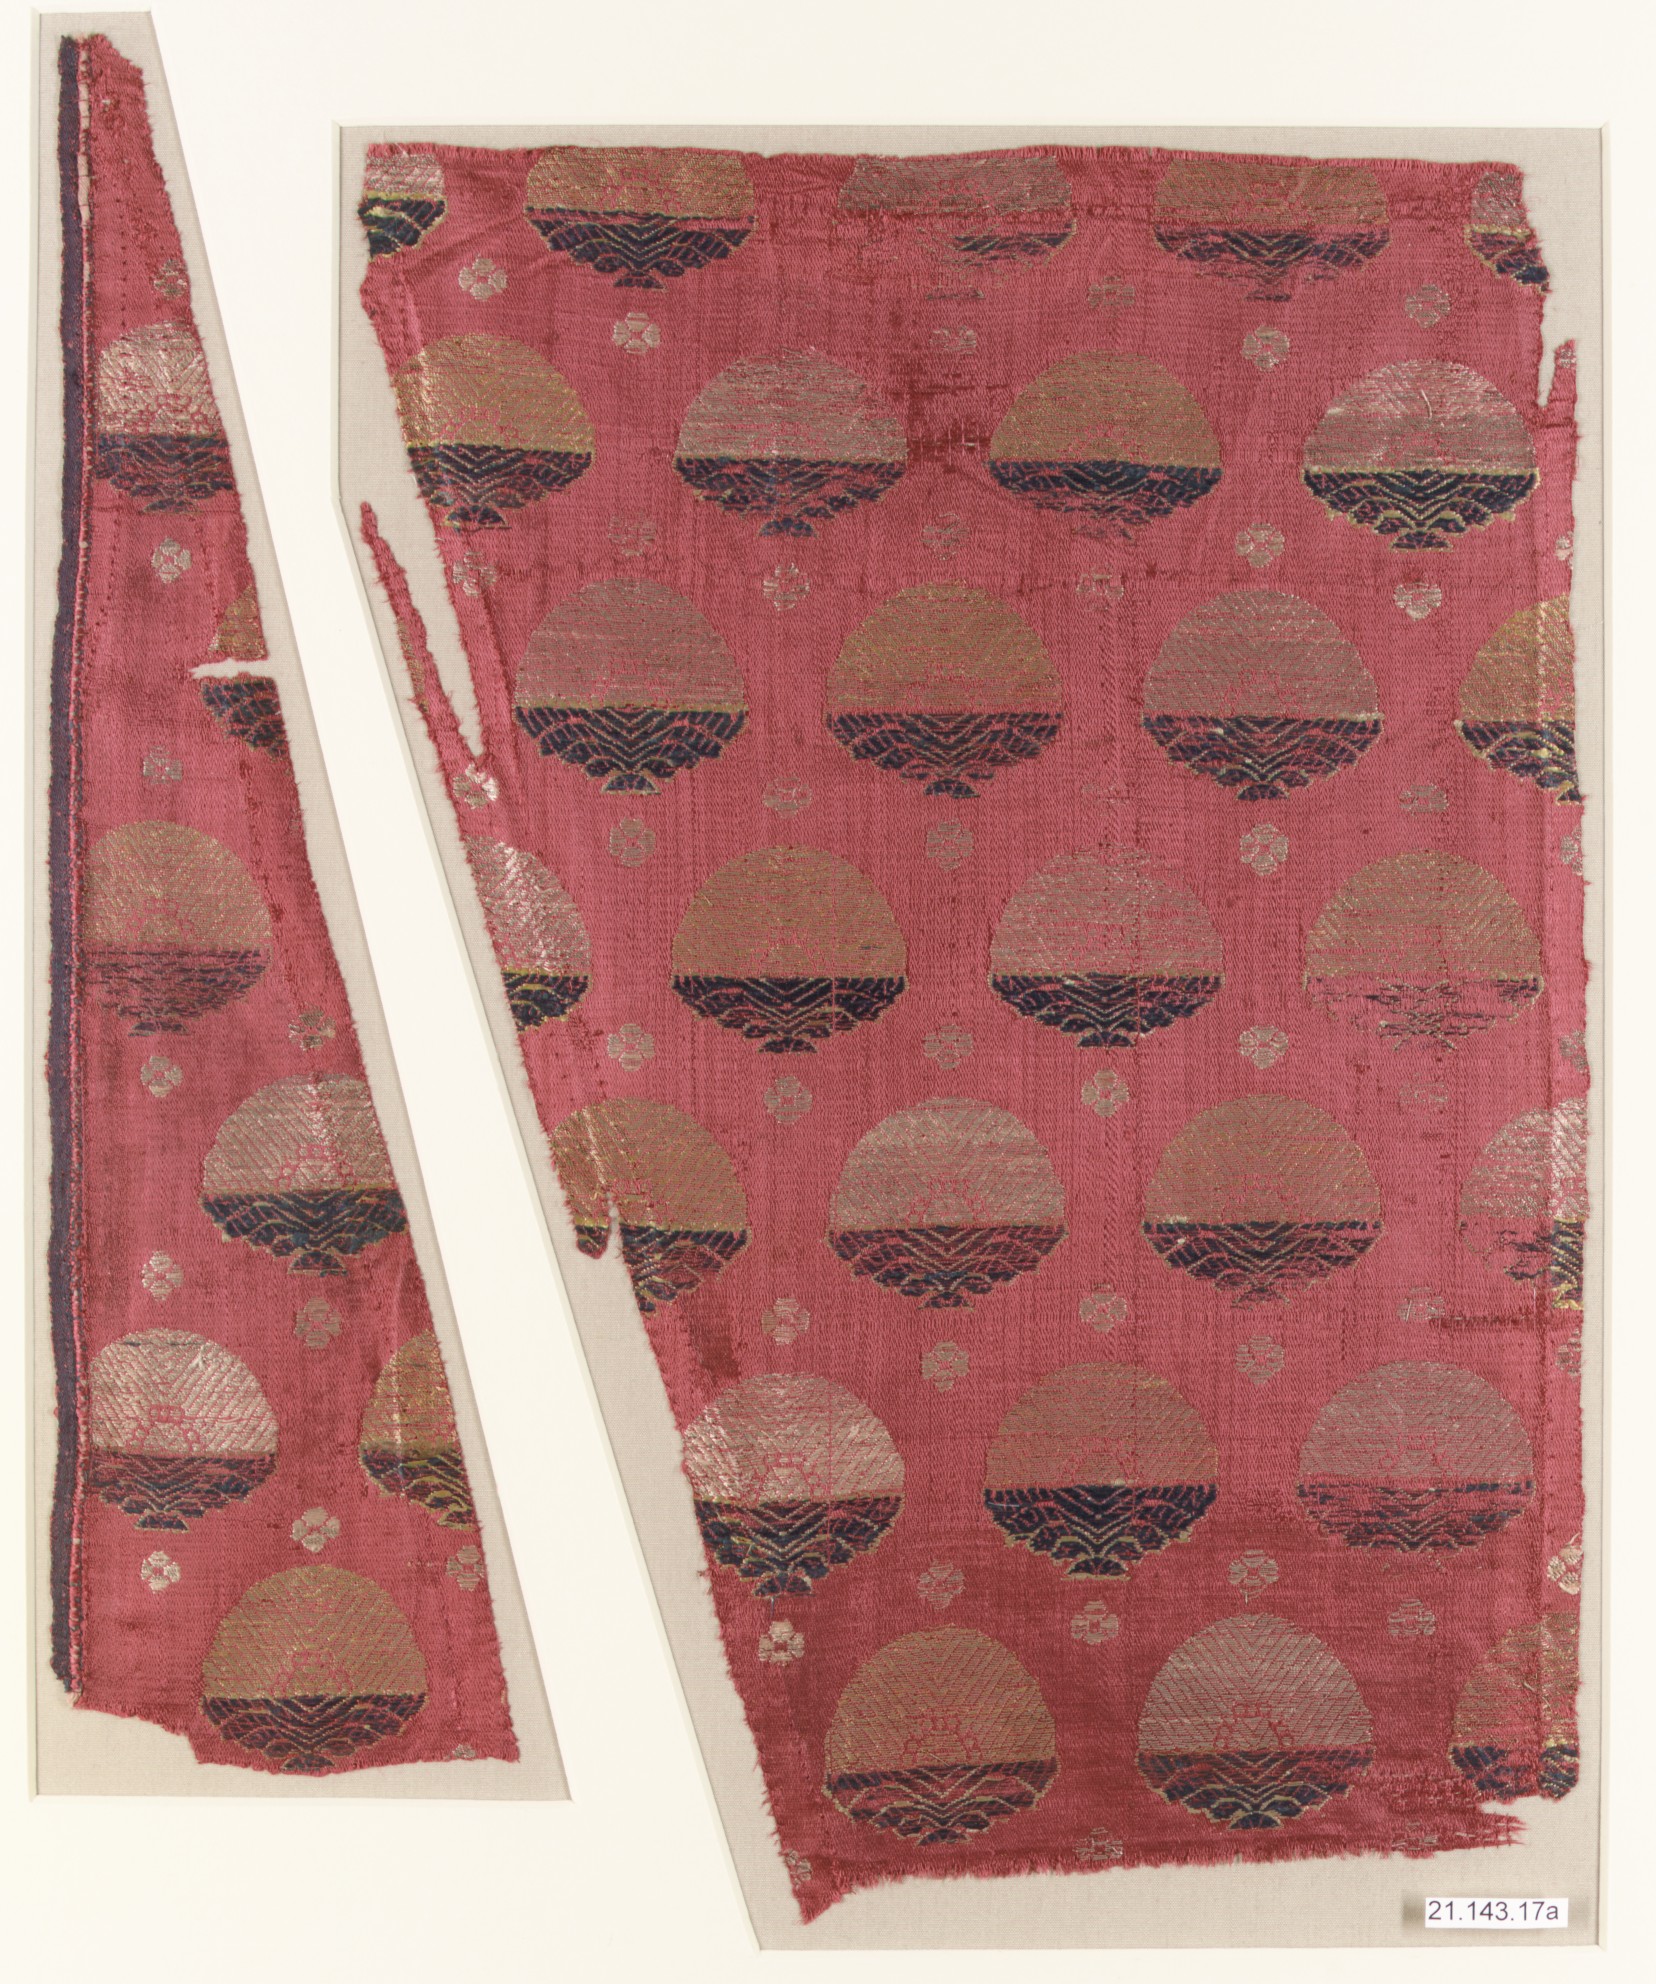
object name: brocade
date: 1801-1900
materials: metal thread, silk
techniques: brocade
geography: india